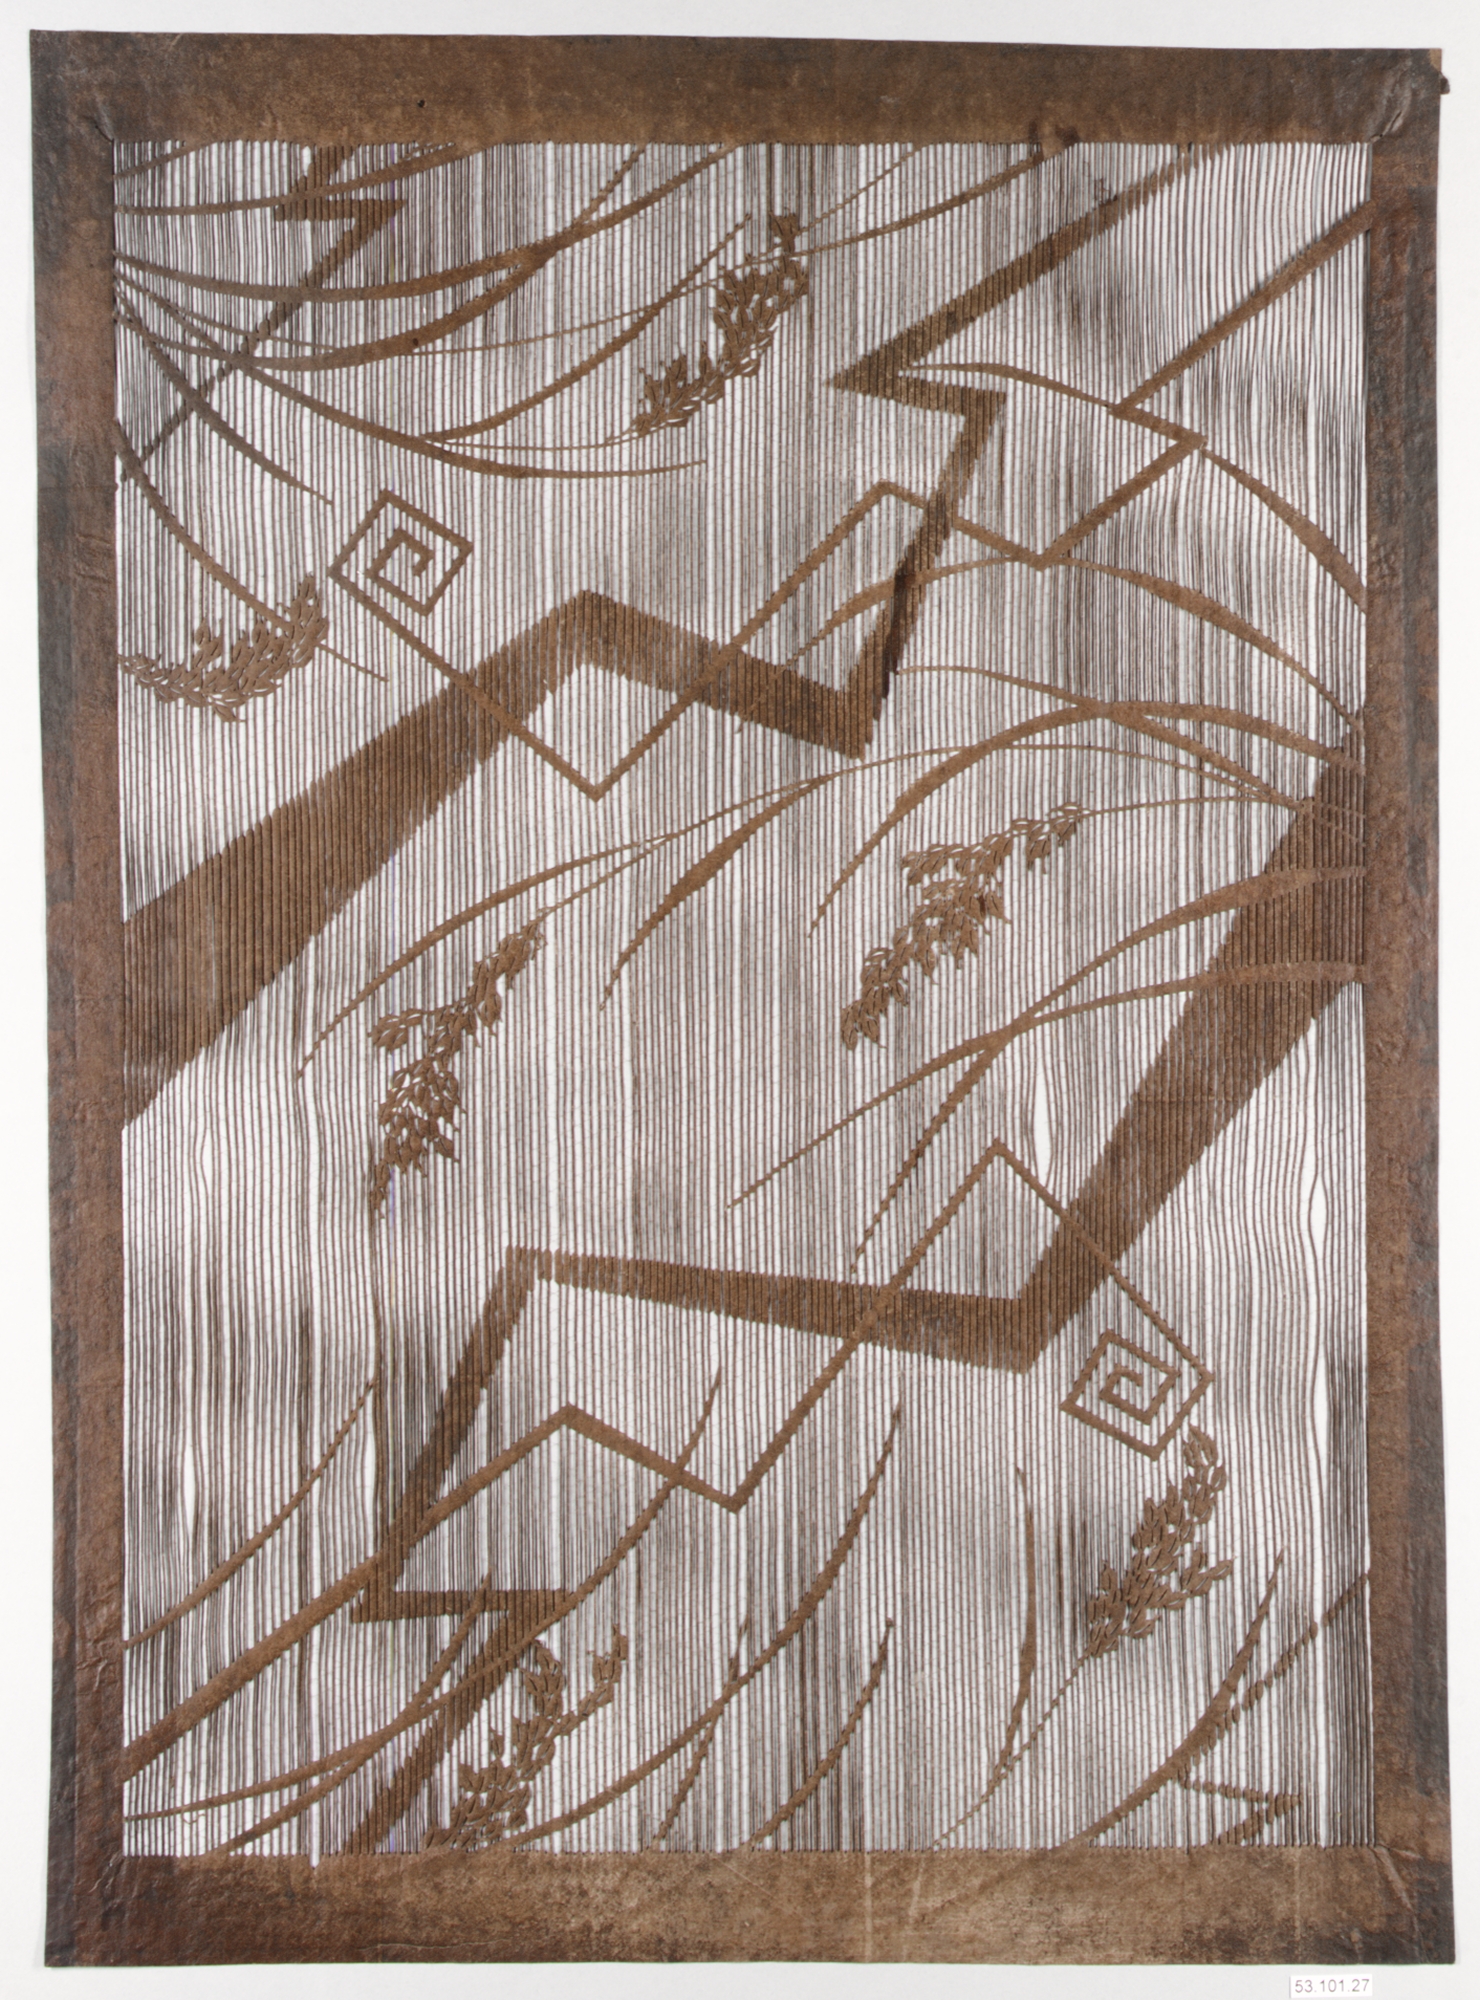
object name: stencil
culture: japanese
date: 1615-1868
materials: paper